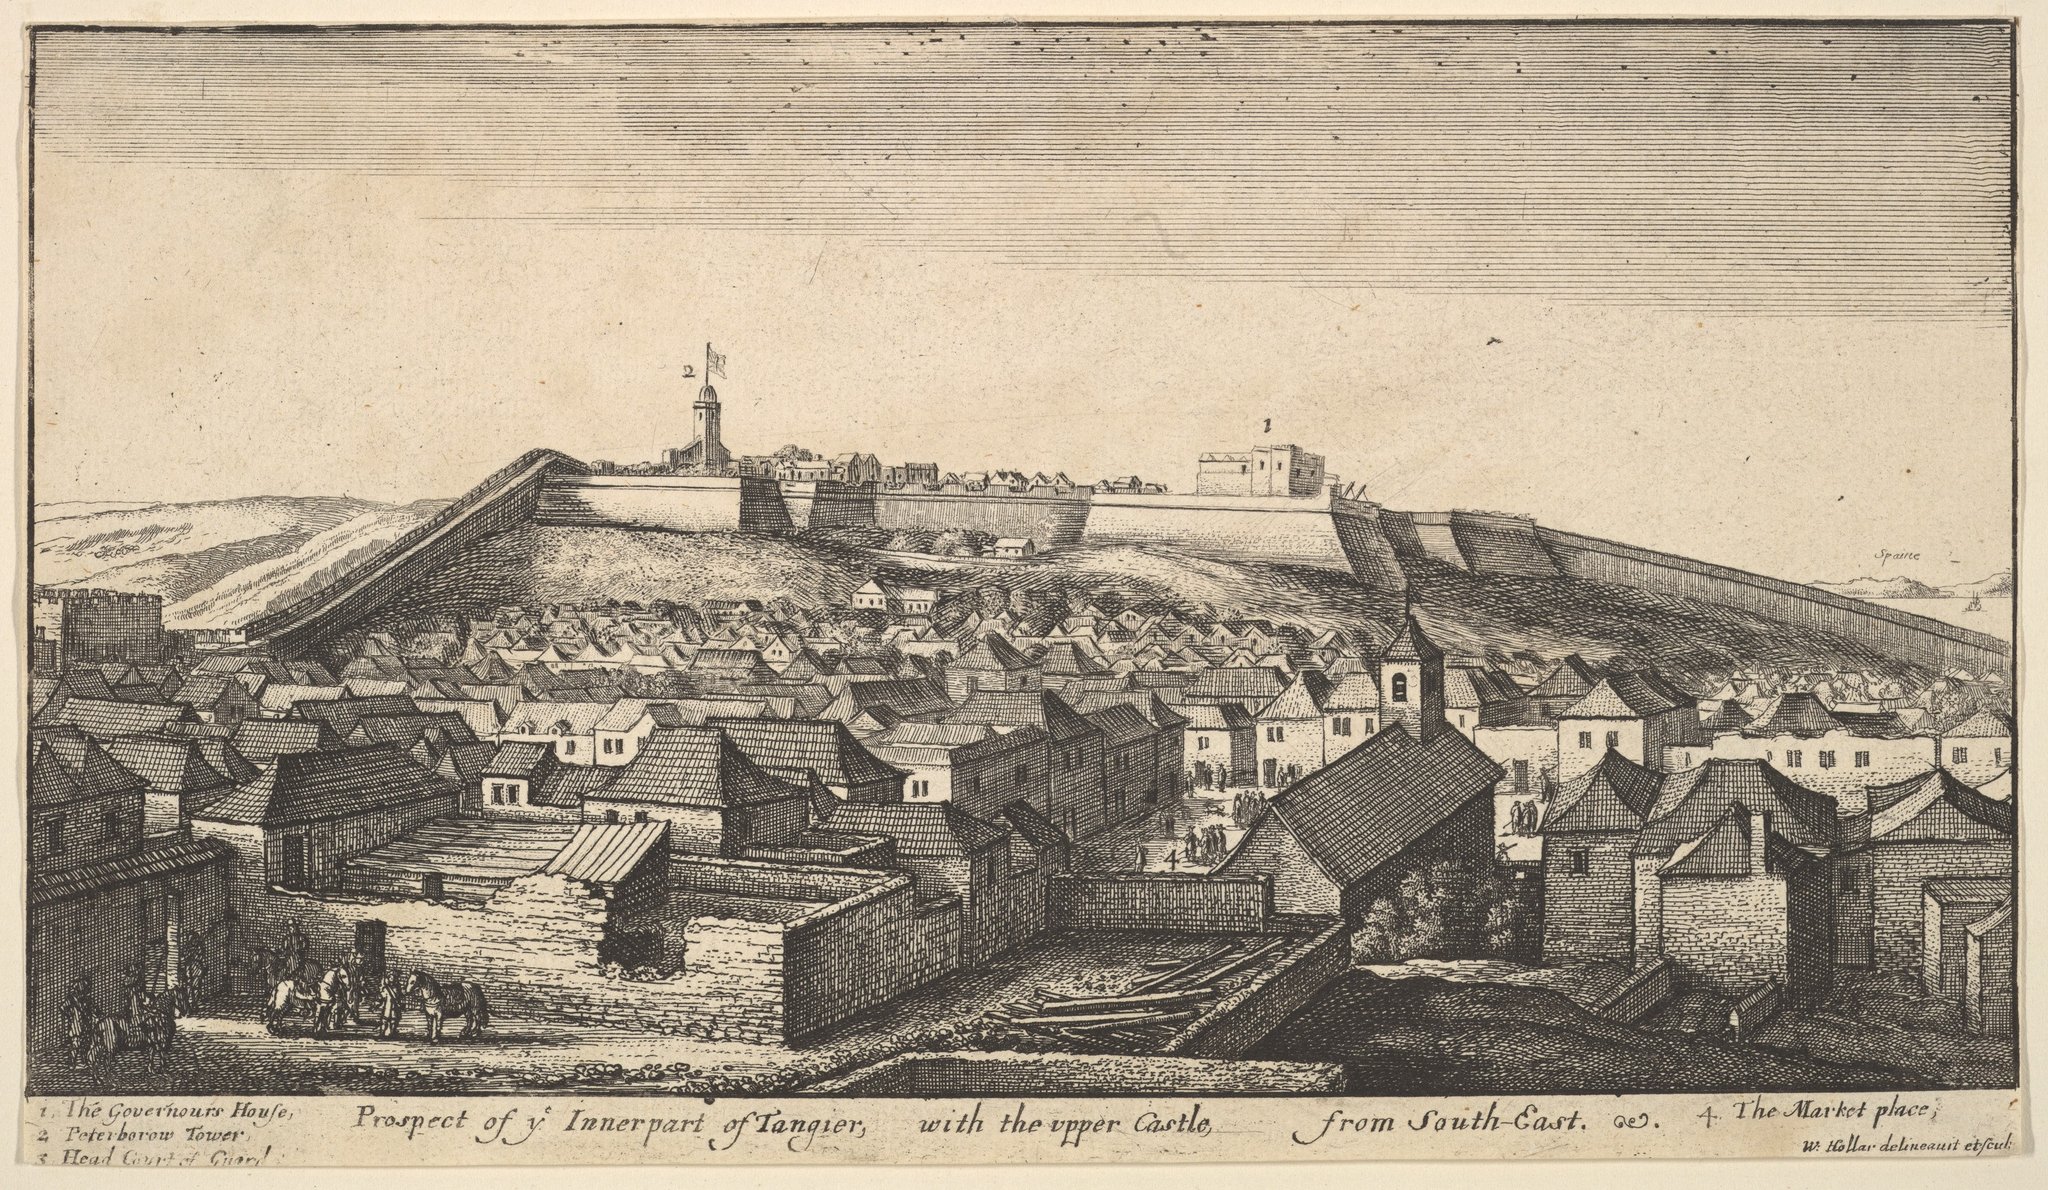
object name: print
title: Prospect of the inner part of Tangier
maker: wenceslaus hollar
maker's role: artist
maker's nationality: bohemian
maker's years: 1607-1677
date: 1670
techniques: etching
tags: fortification,houses,horses